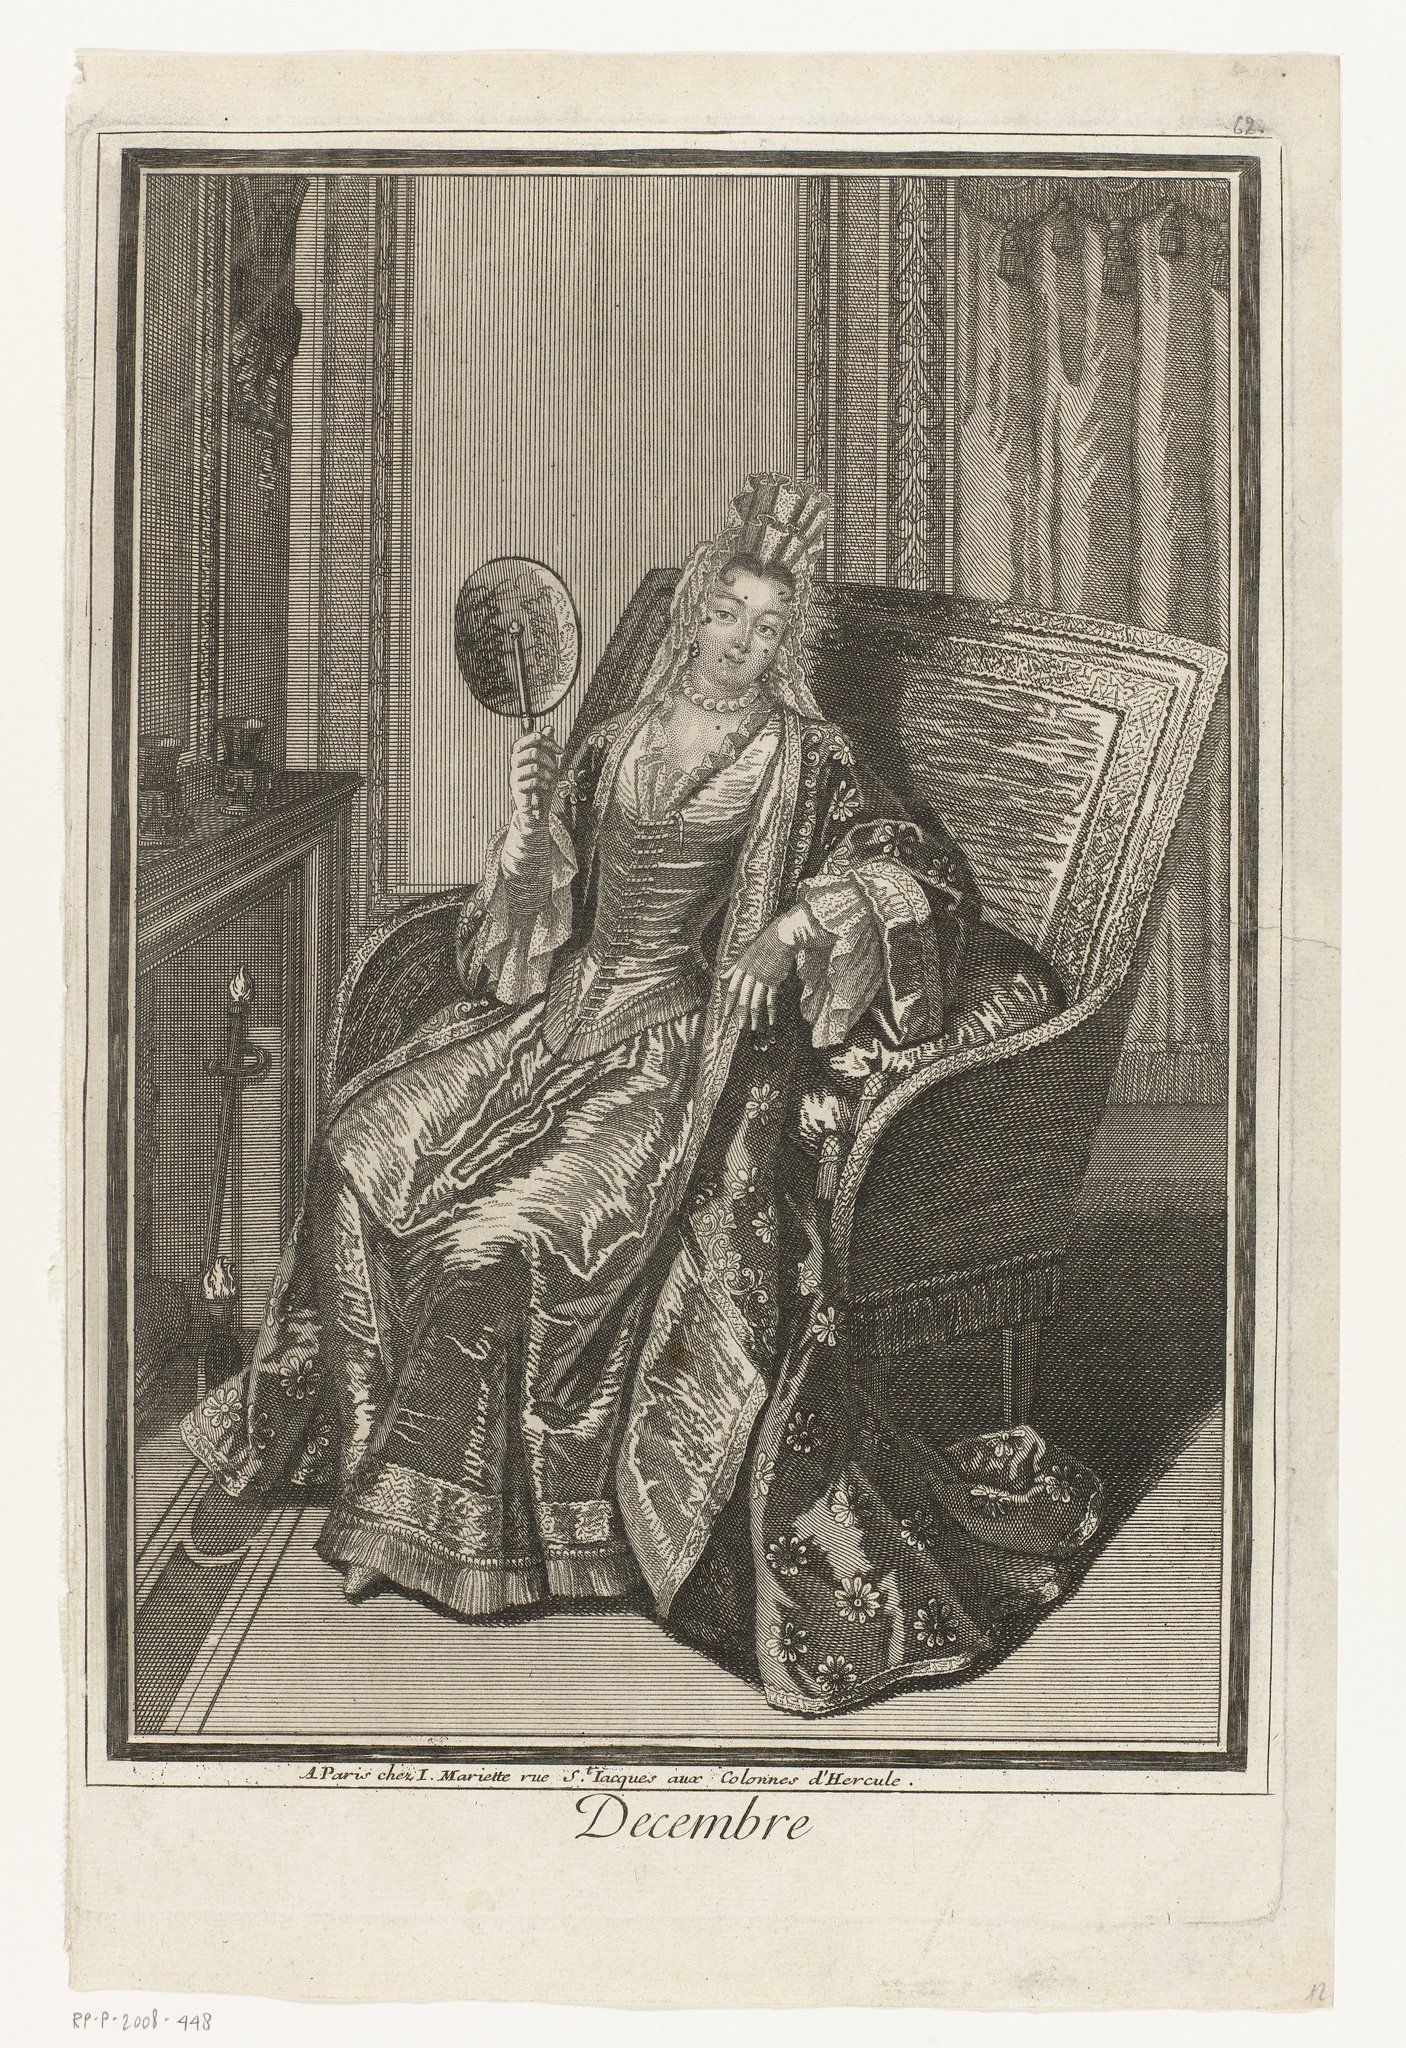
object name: print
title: December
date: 1670-1742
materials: paper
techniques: engraving, etching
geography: paris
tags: december; 'decembre' (ripa), open hearth, fire-place, the twelve months (especially personifications); 'mese in generale' (ripa)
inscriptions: collector's mark: Lugt 2760, collector's mark: Lugt 2228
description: Maakt deel uit van een twaalfdelige serie met personificaties van de twaalf maanden. Mogelijk betreft de prentmaker een lid van de familie Bonnart.